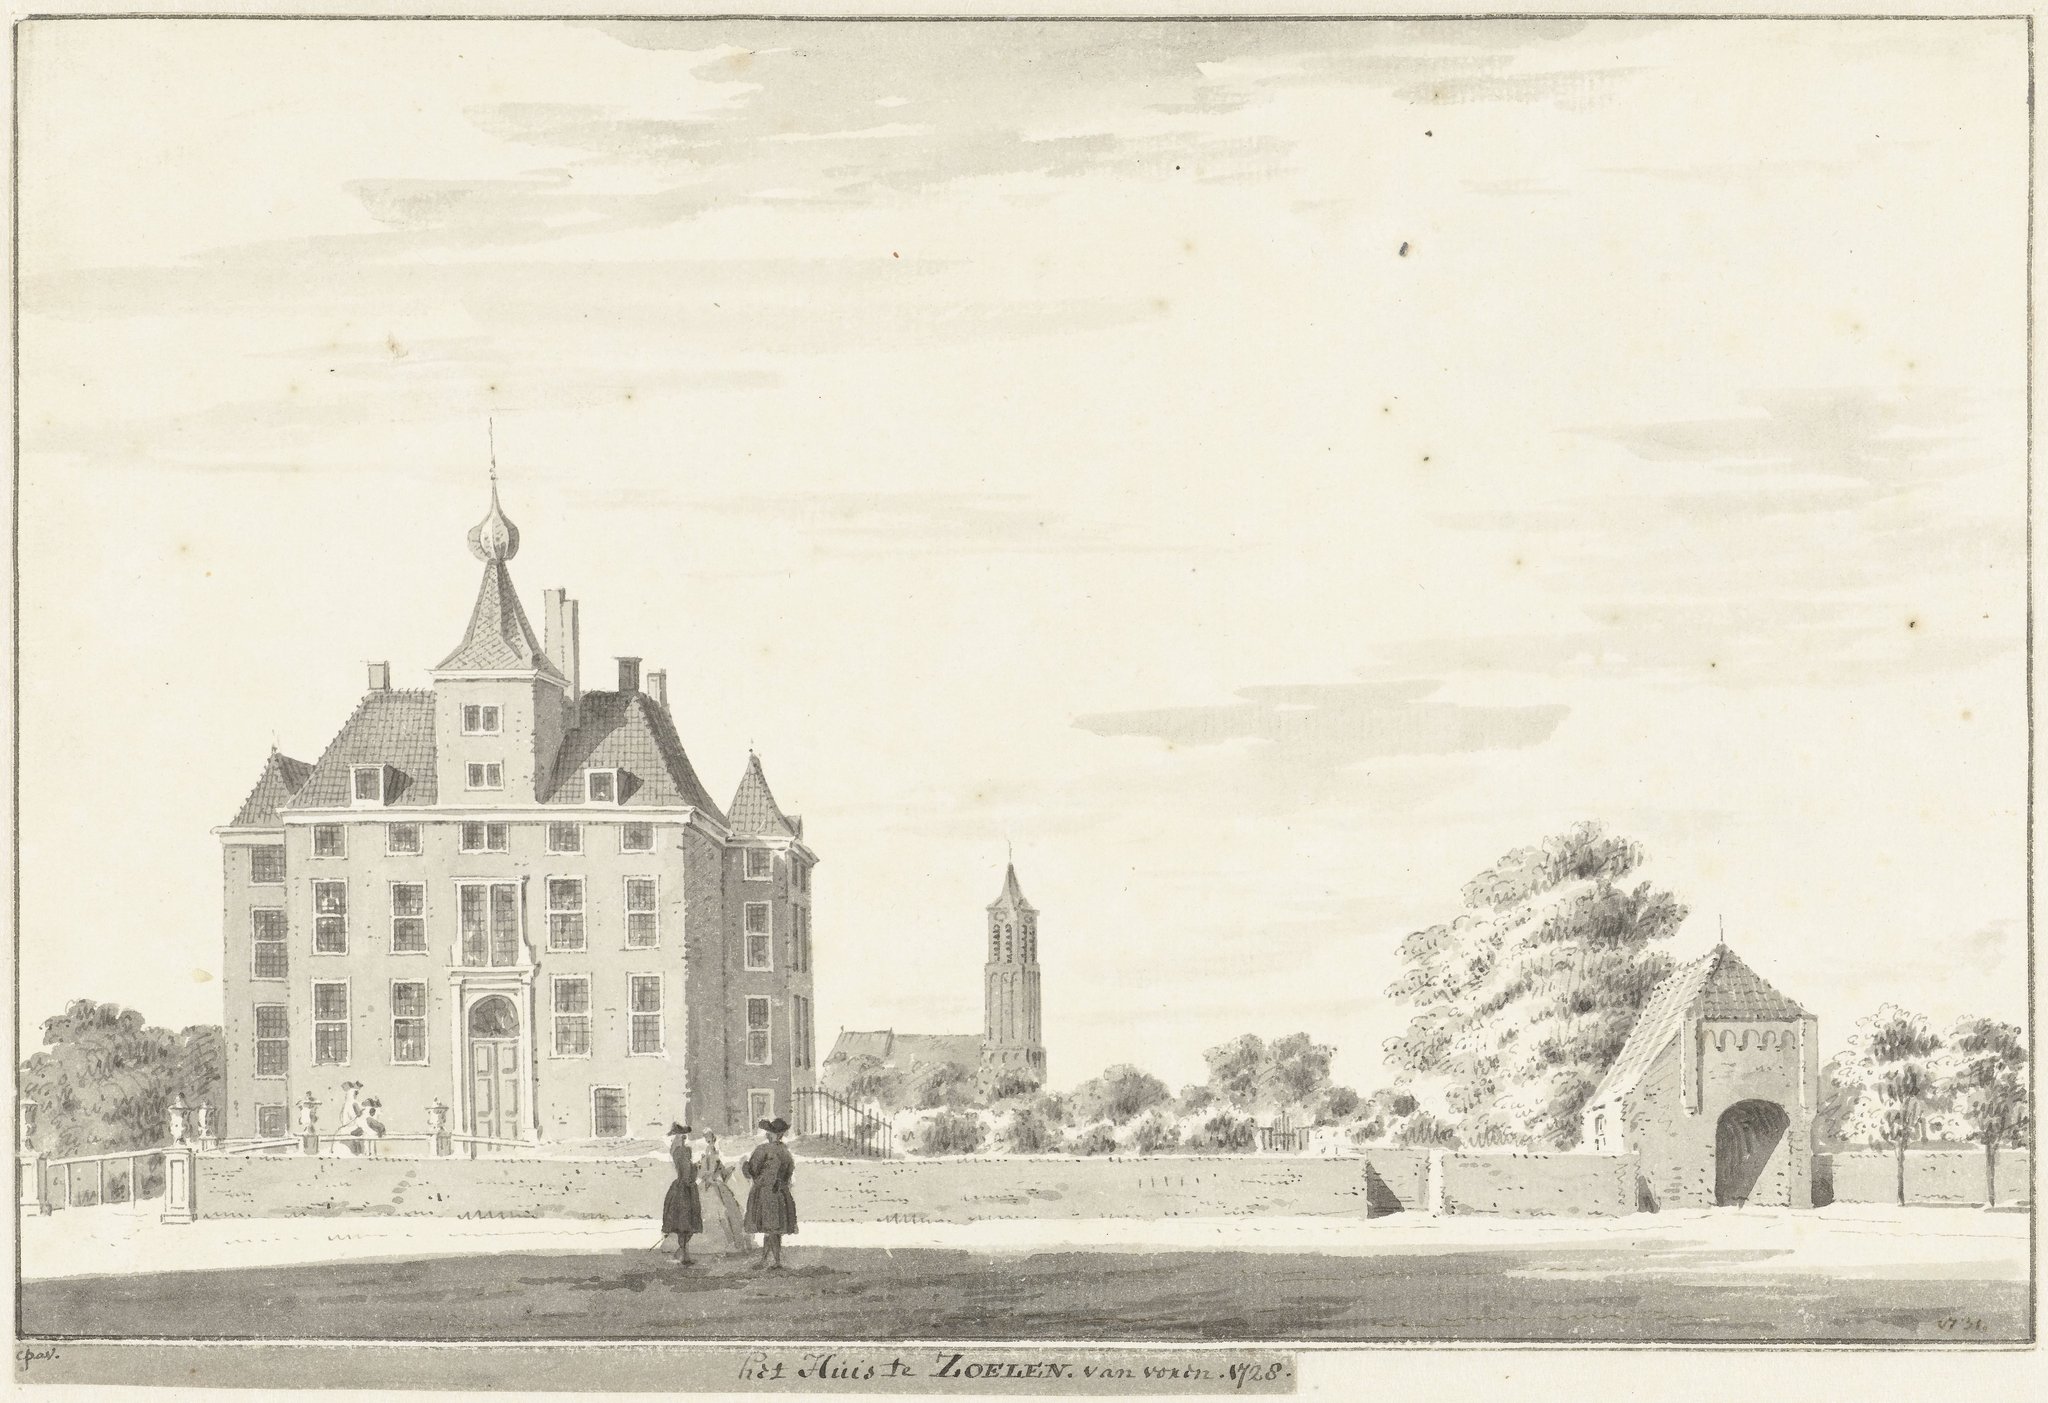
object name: drawing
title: Het kasteel te Zoelen, Gelderland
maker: cornelis pronk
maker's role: draughtsman, painter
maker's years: 1691-1759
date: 1728-1731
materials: ink, paper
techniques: brush, pen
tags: castle, rural housing, e.g. country-house, villa, cottage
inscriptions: inscription: ‘1731 / cpav / het Huis te ZOELEN van voren. 1728.’